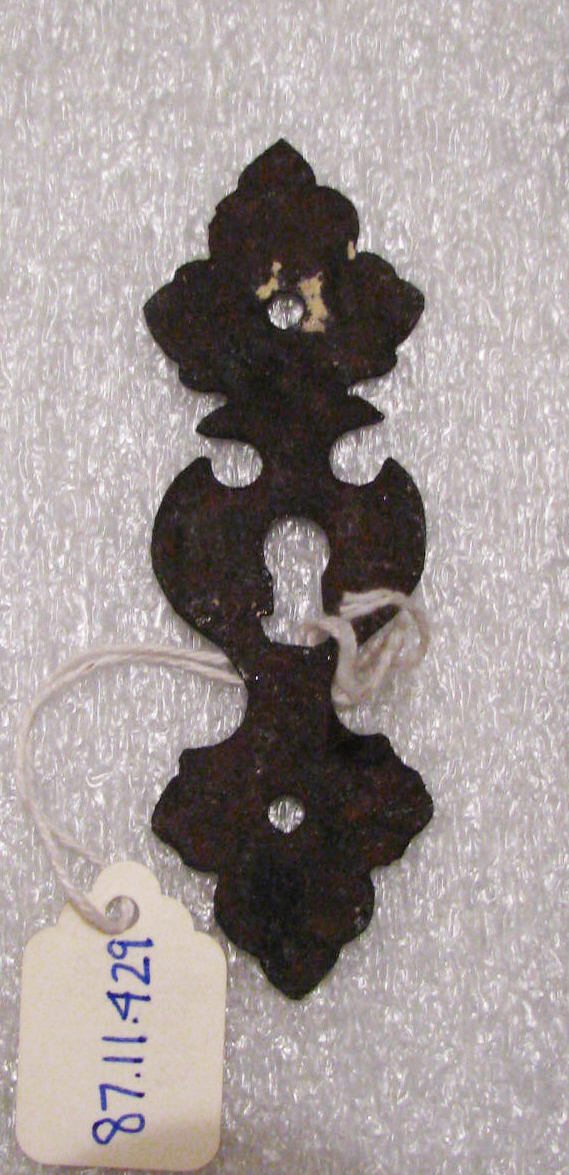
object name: escutcheon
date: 1580-1620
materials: iron